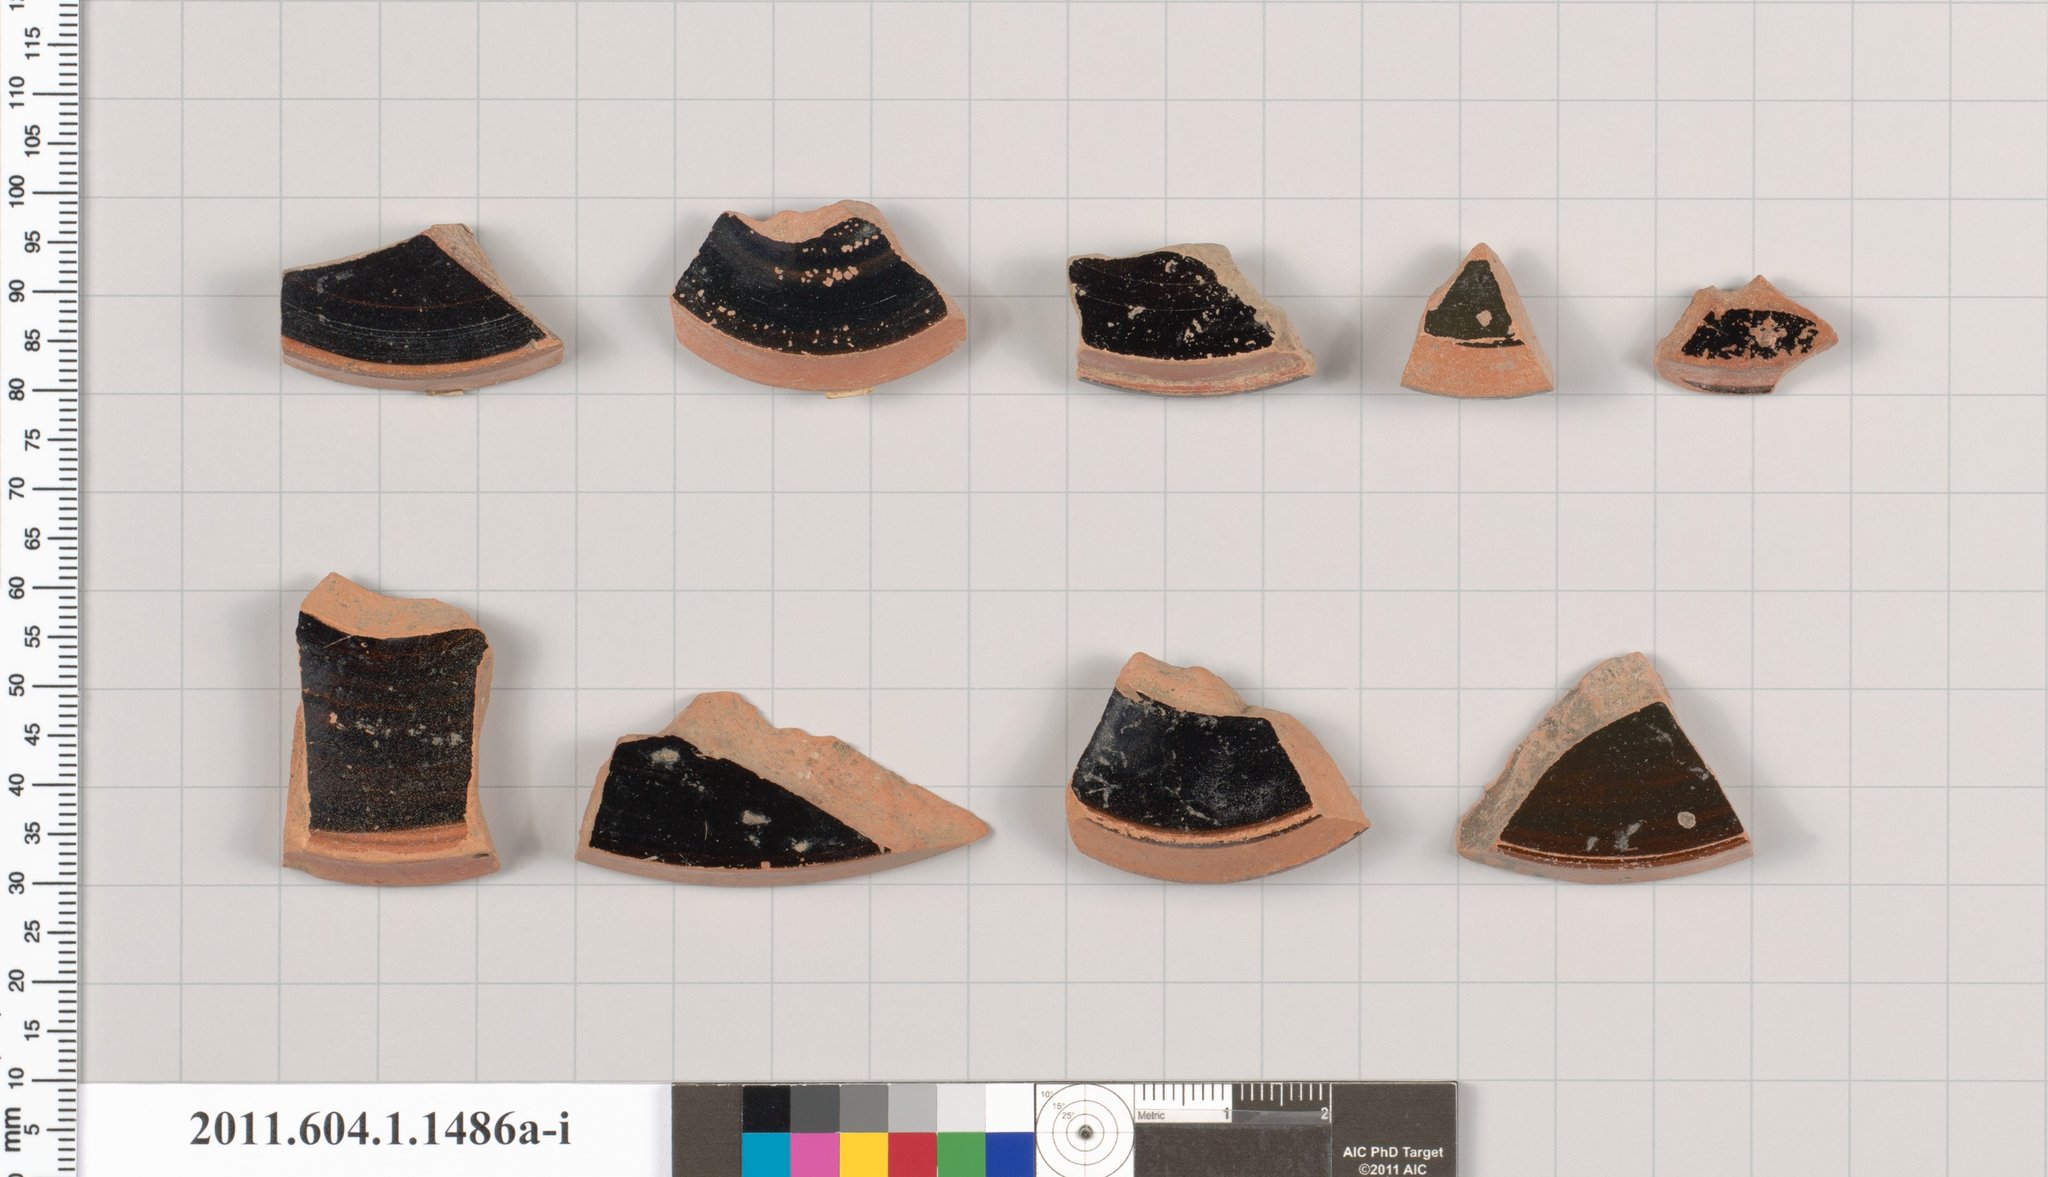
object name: kylix fragment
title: Terracotta fragments of kylikes (drinking cups)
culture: greek, attic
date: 500-401 BCE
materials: terracotta